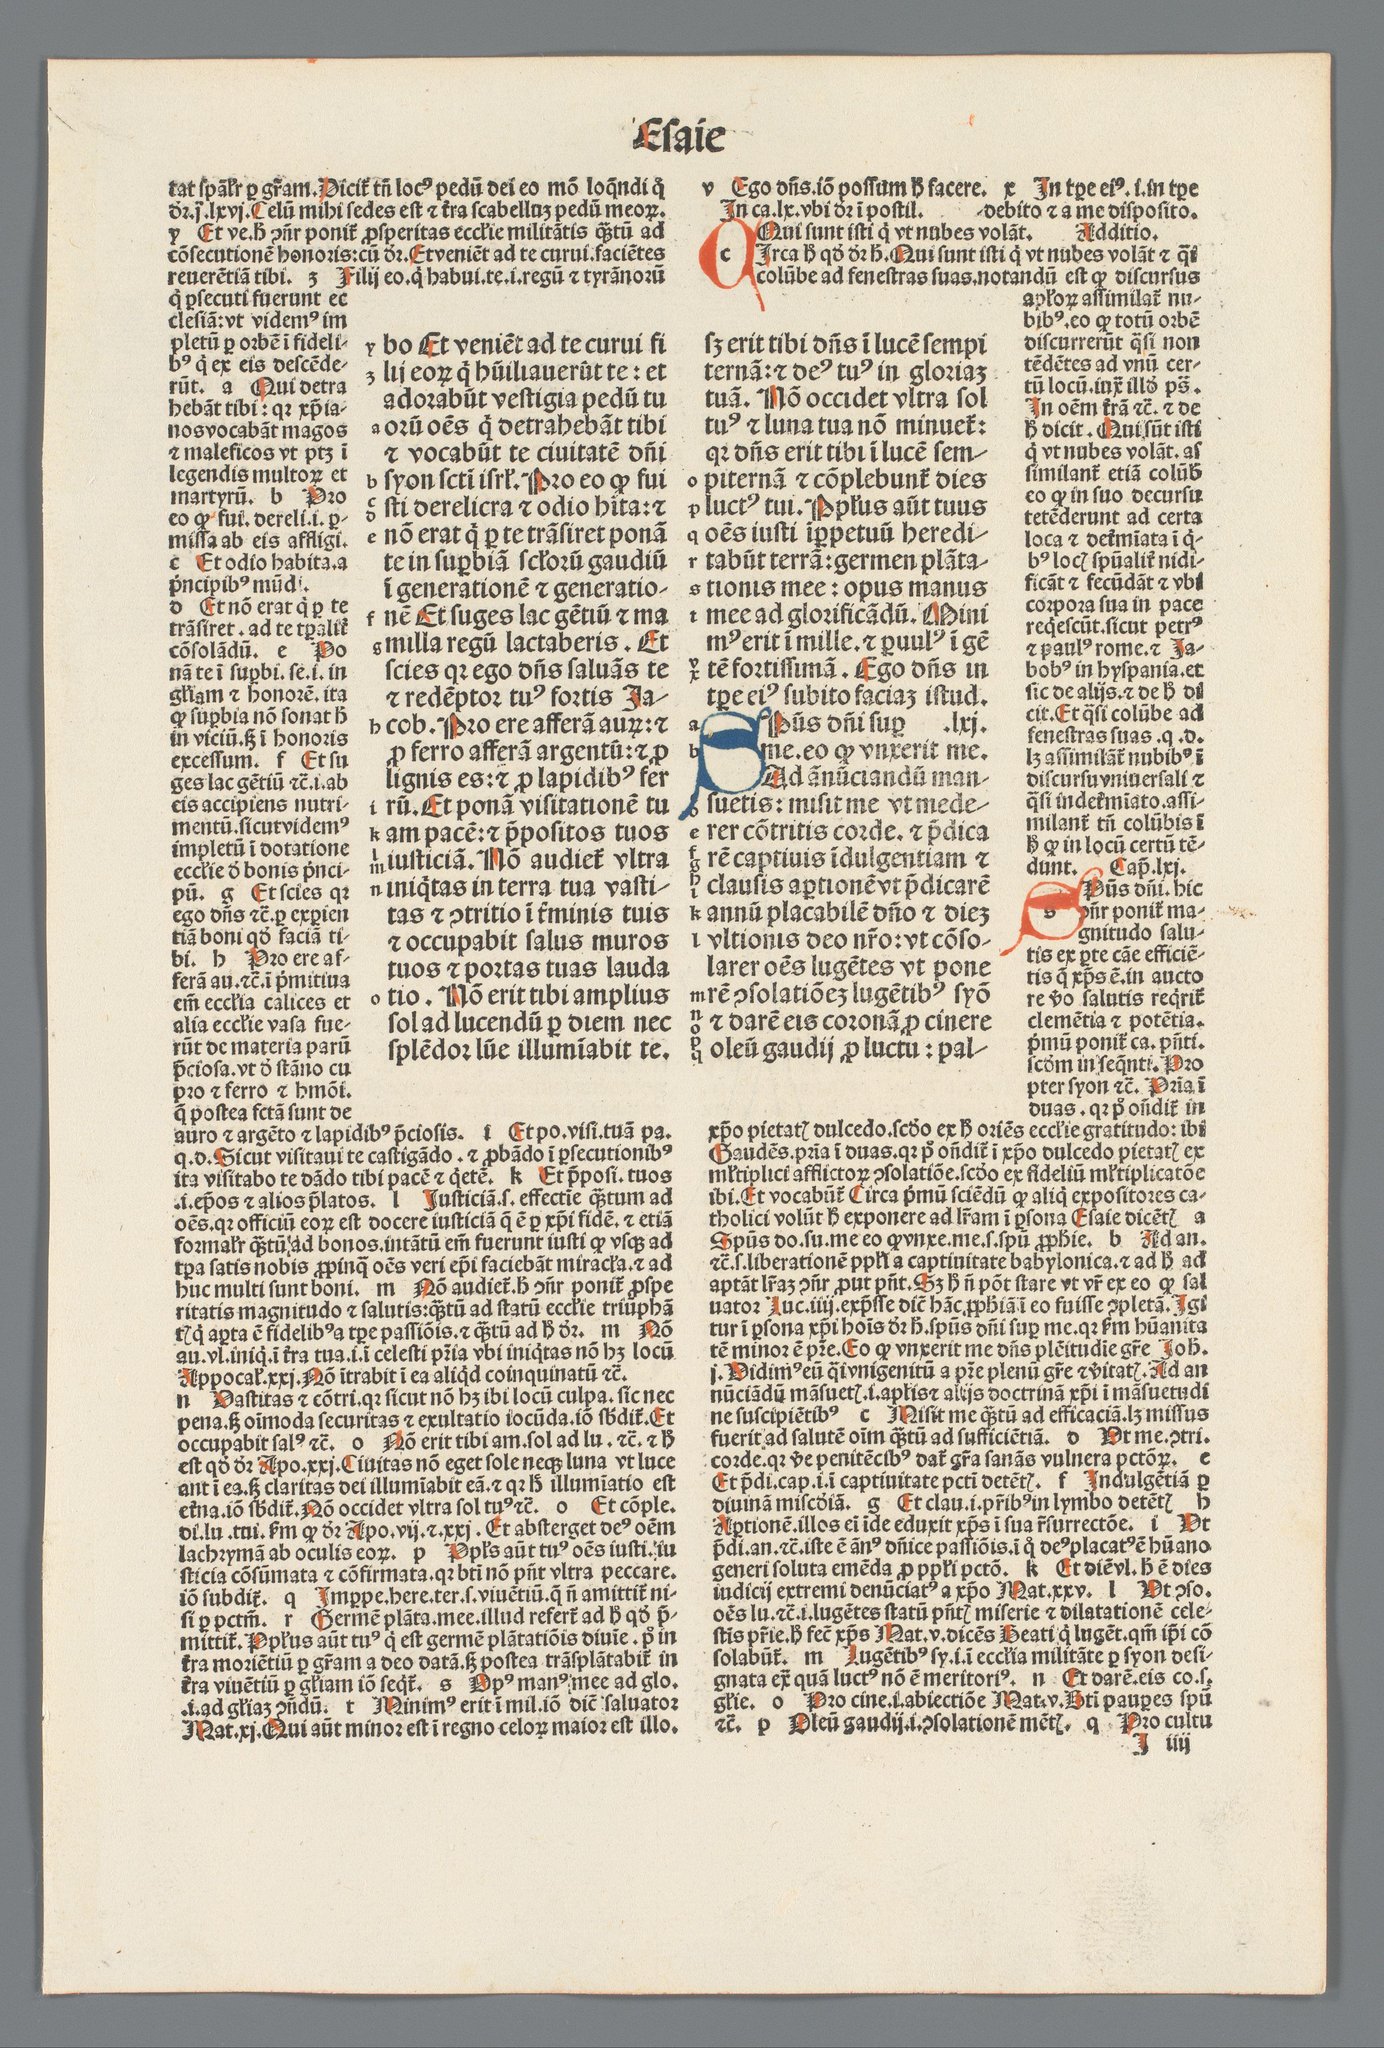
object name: text sheet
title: Bladzijde uit Biblia Latina cum Postillis Nicolai de Lyra, 1493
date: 1493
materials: paper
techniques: hand coloring, letterpress printing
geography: nuremberg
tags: the bible as a book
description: Bladzijde uit: Lyra, Nicolaas van. Biblia Latina cum Postillis Nicolai de Lyra. Neurenberg: Anton Koberger, 1493, dl. 3.